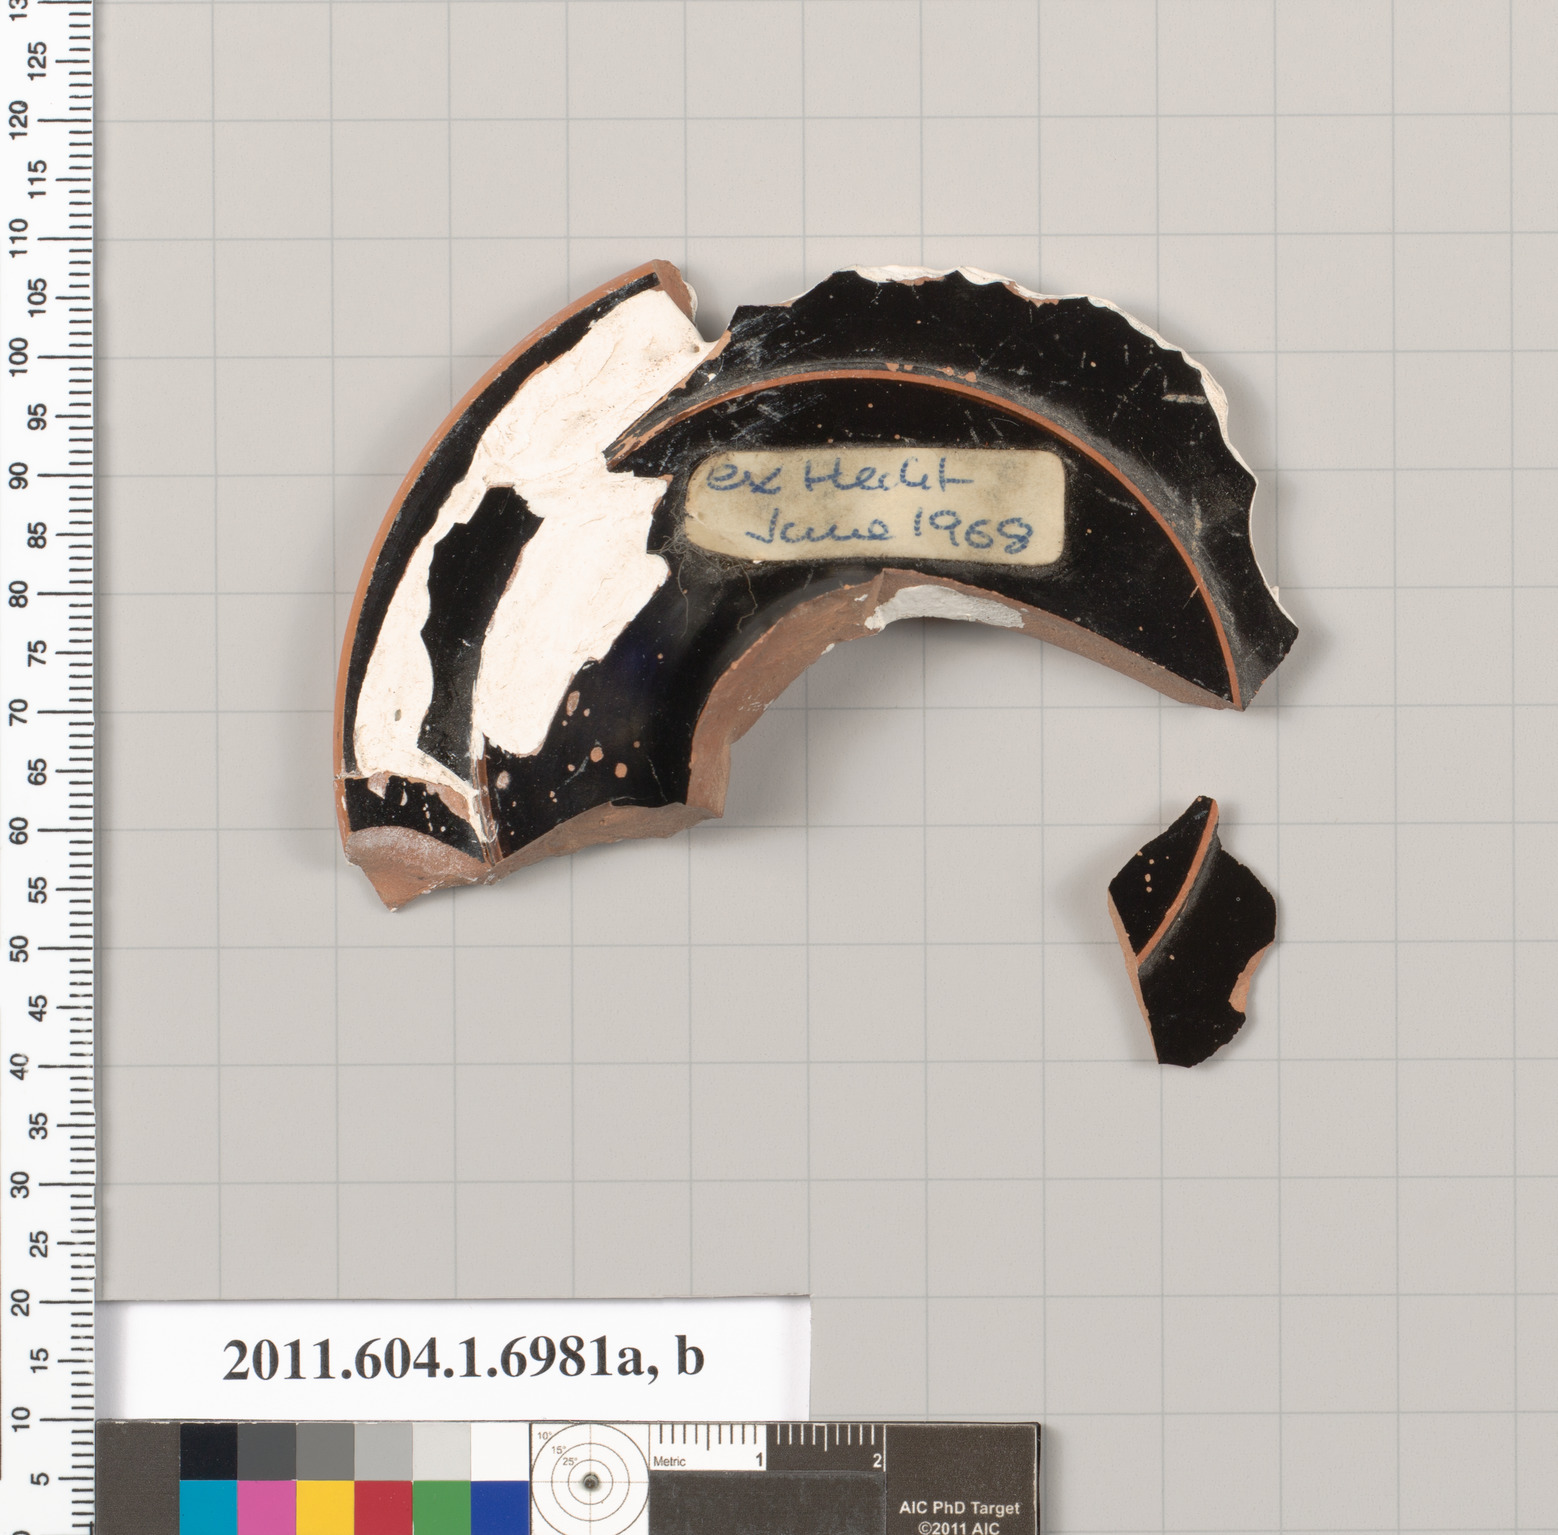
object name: kylix fragment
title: Terracotta fragments of a kylix (drinking cup)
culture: greek, attic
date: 490-470 BCE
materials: terracotta